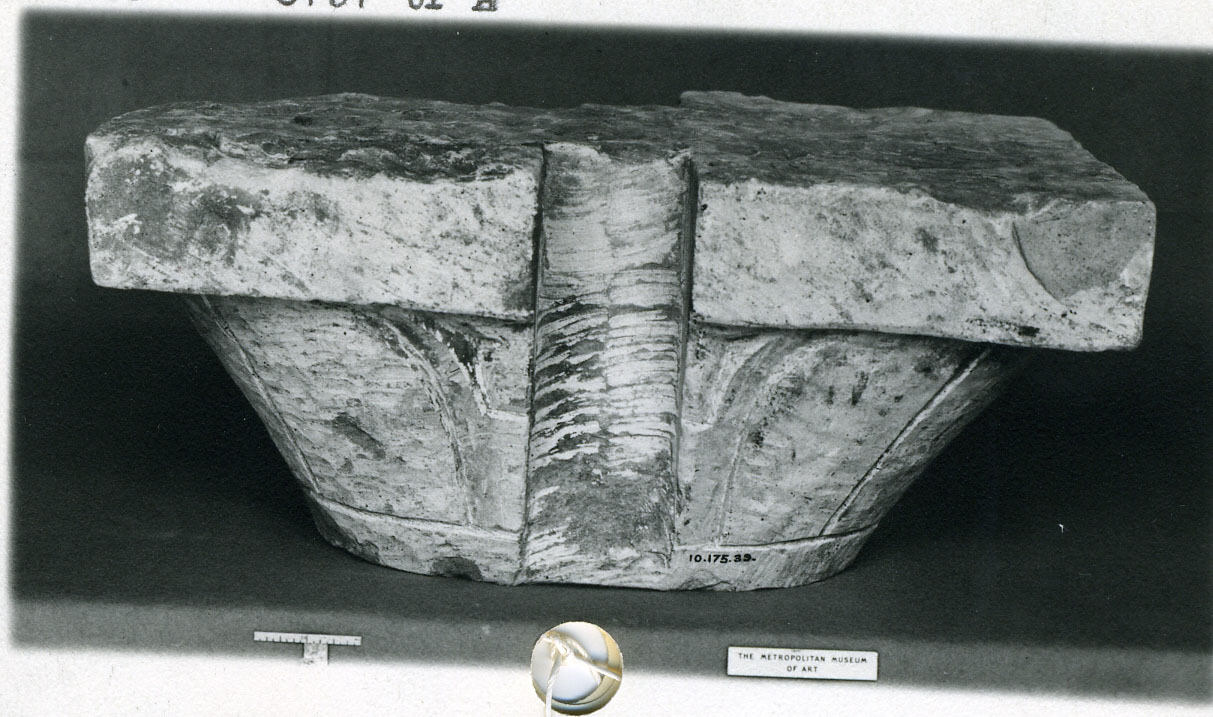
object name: capital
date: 501-700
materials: limestone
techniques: carving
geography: egypt